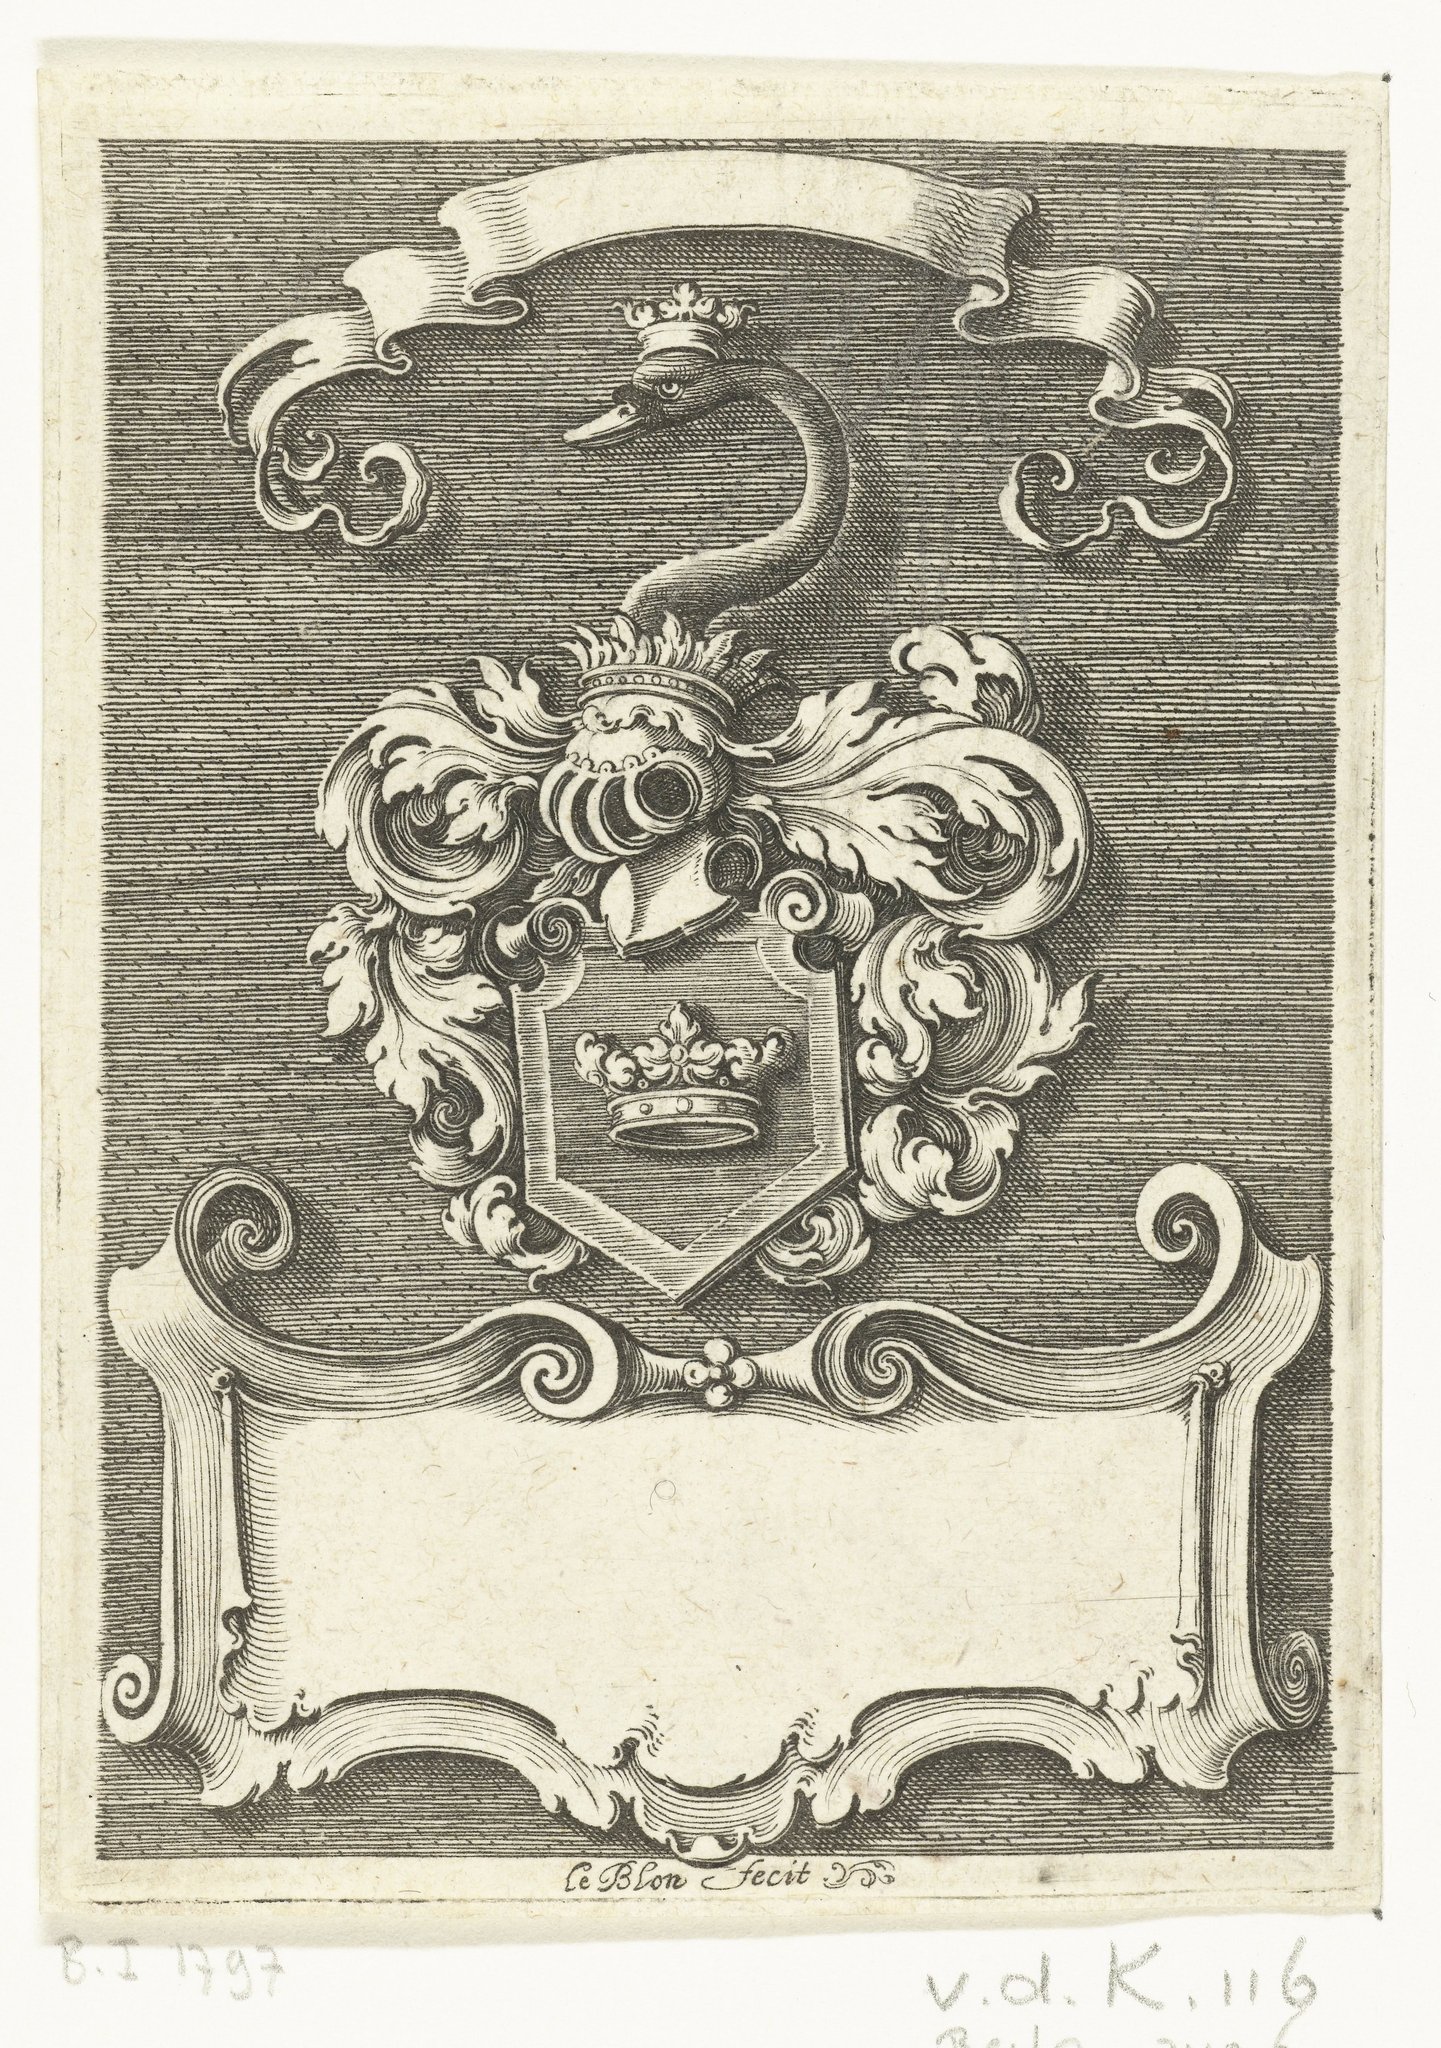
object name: print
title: Onbekend wapenschild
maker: michiel le blon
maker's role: print maker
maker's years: 1587-1656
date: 1611-1625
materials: paper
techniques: engraving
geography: amsterdam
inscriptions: collector's mark: Lugt 240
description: Bovenaan hangt een banderol en onderaan een cartouche, beide leeg. Op het wapenschild staat een kroon. Uit serie van 20 bladen.